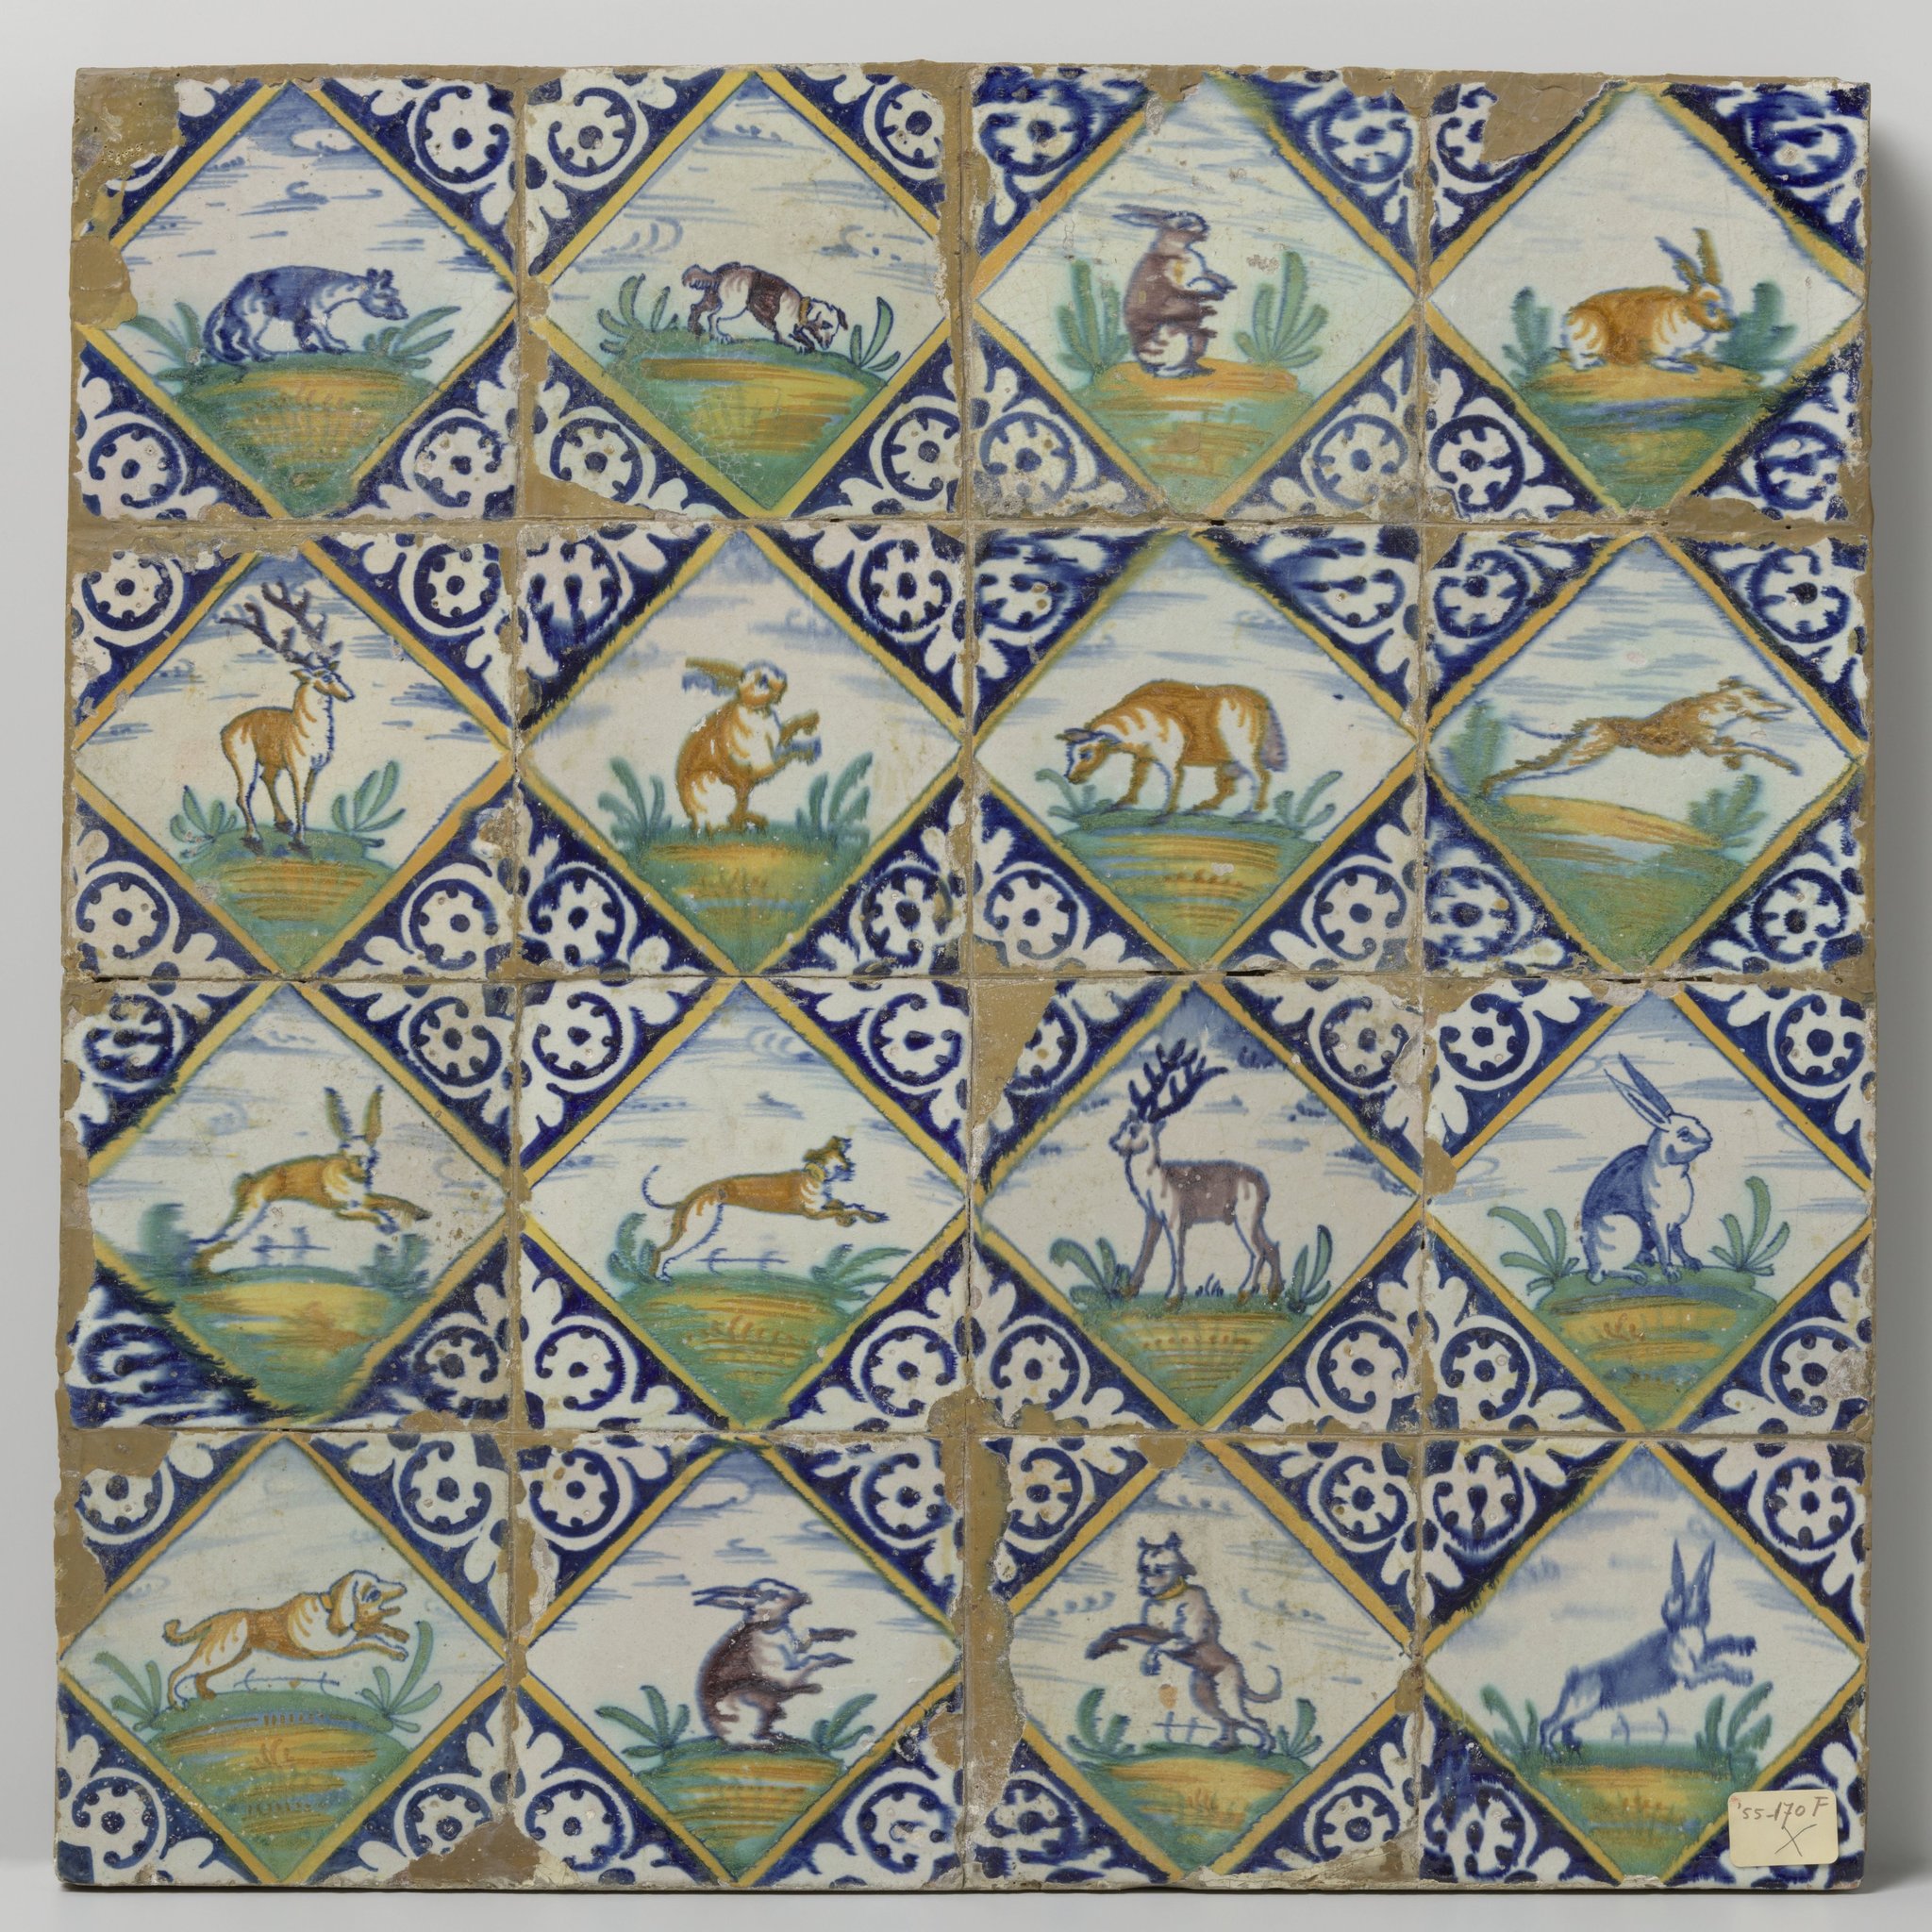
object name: tile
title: Veld van zestien tegels met dieren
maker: Anonymous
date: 1580-1625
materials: earthenware, glaze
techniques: maiolica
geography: netherlands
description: Veld van zestien tegels (4 x 4) elk met een veelkleurig (blauw, oranje, geel, groen en paars) geschilderd dier binnen een kwadraat. In de hoeken, vultechniek ornament.